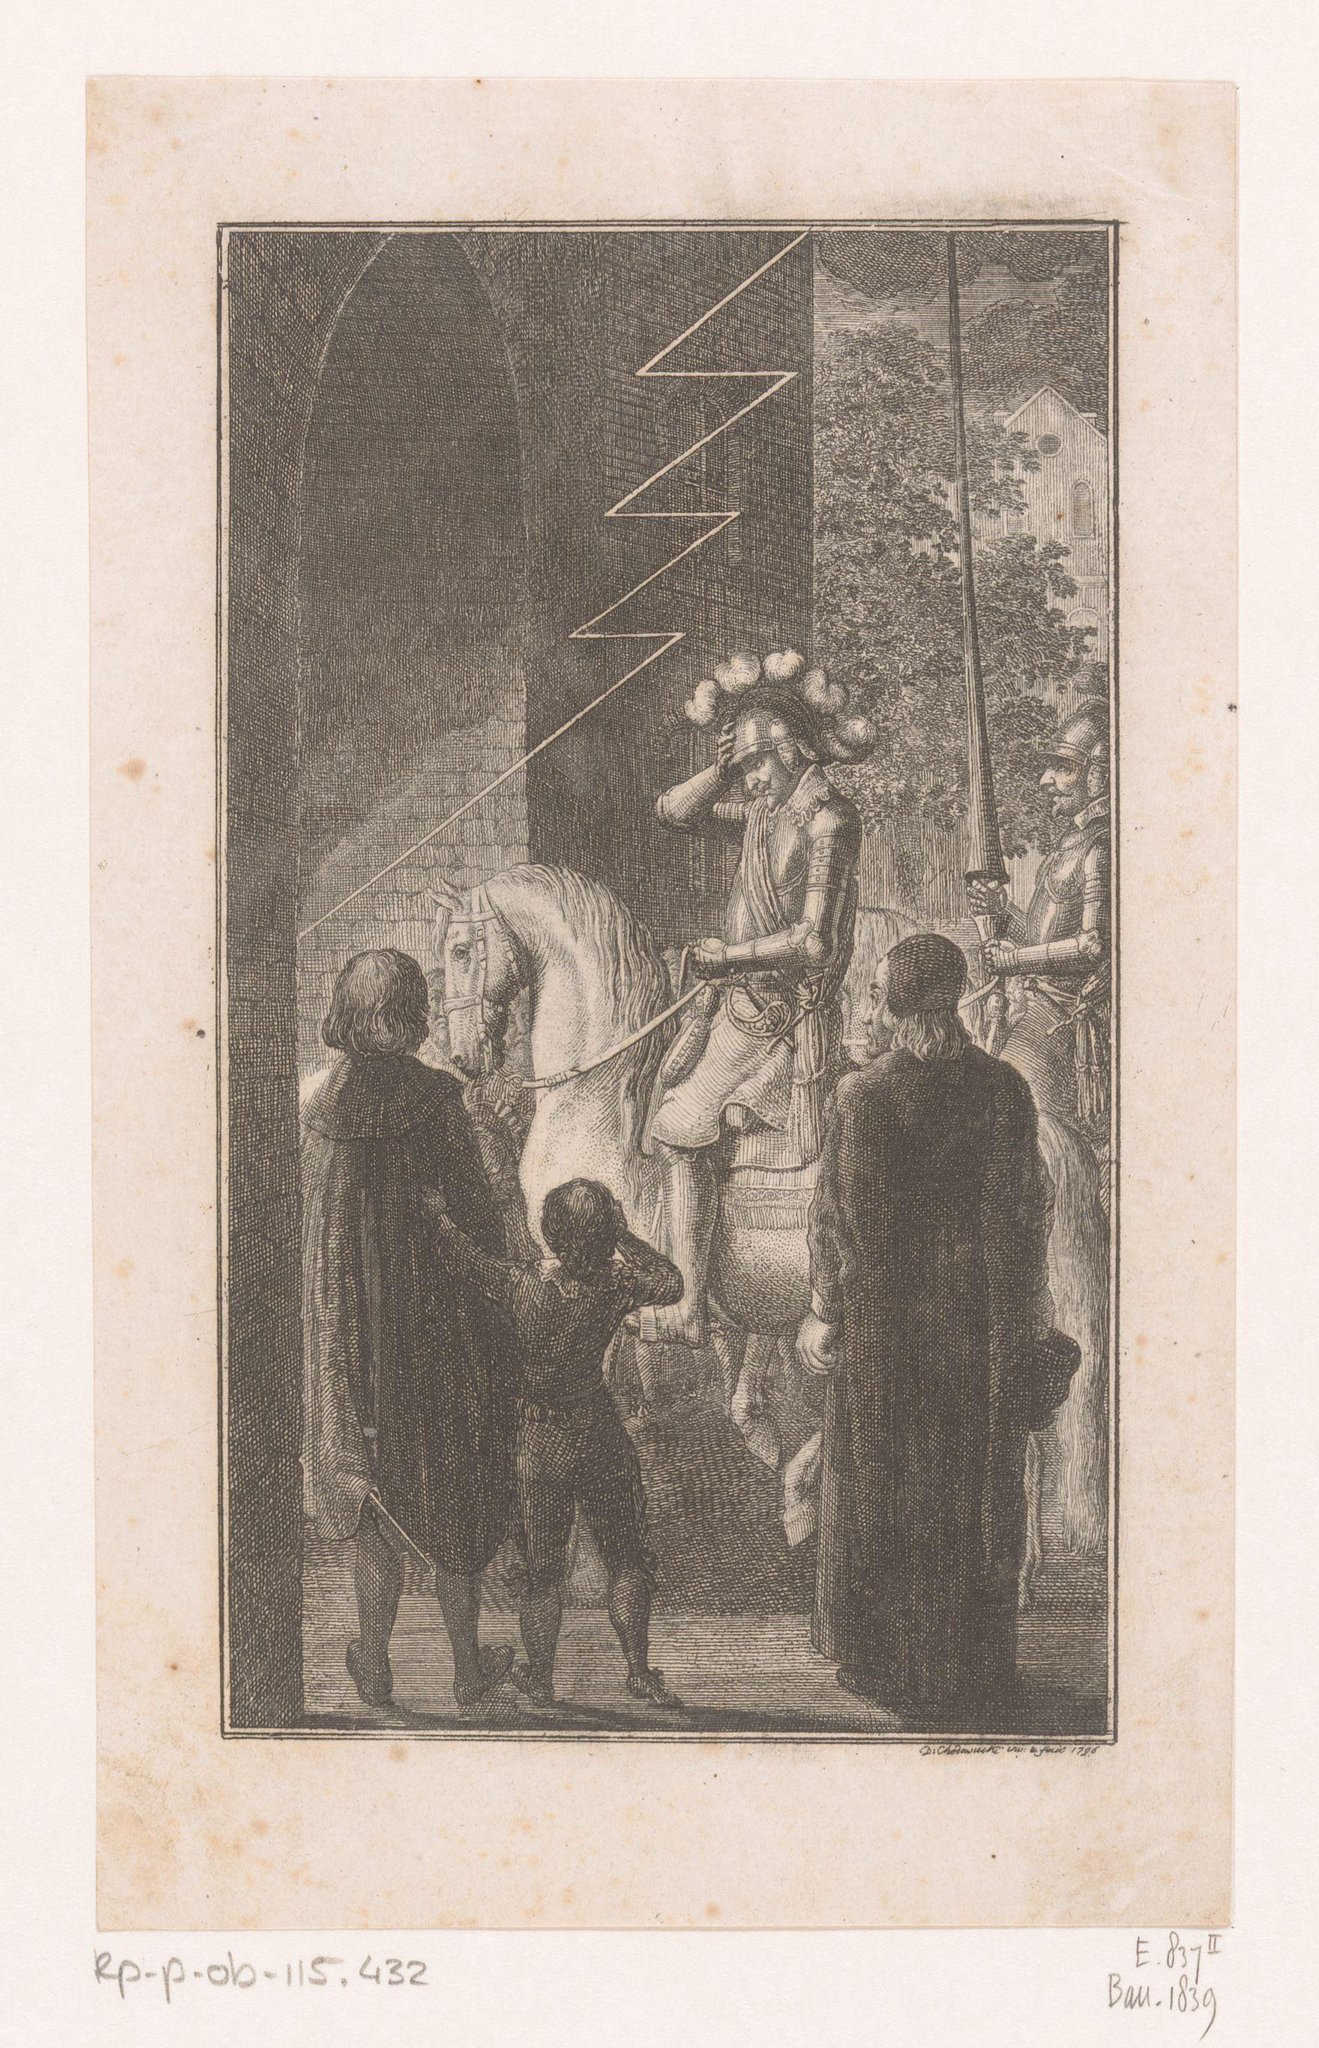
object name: print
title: Gustaaf Adolf van Zweden krijgt een teken van hogerhand als hij Landshut binnen gaat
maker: daniel nikolaus chodowiecki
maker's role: draughtsman, print maker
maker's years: 1726-1801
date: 1796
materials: paper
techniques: etching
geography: berlin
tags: riding a horse, ass, or mule; rider, horseman, history, lightning, flash of lightning, thunderbolt, city-gate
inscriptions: collector's mark: Lugt 2228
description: Prent gebruikt voor: Deutsche Monatsschrift (...). 3 dln. Leipzig: Sommersche Buchhandlung, 1796.